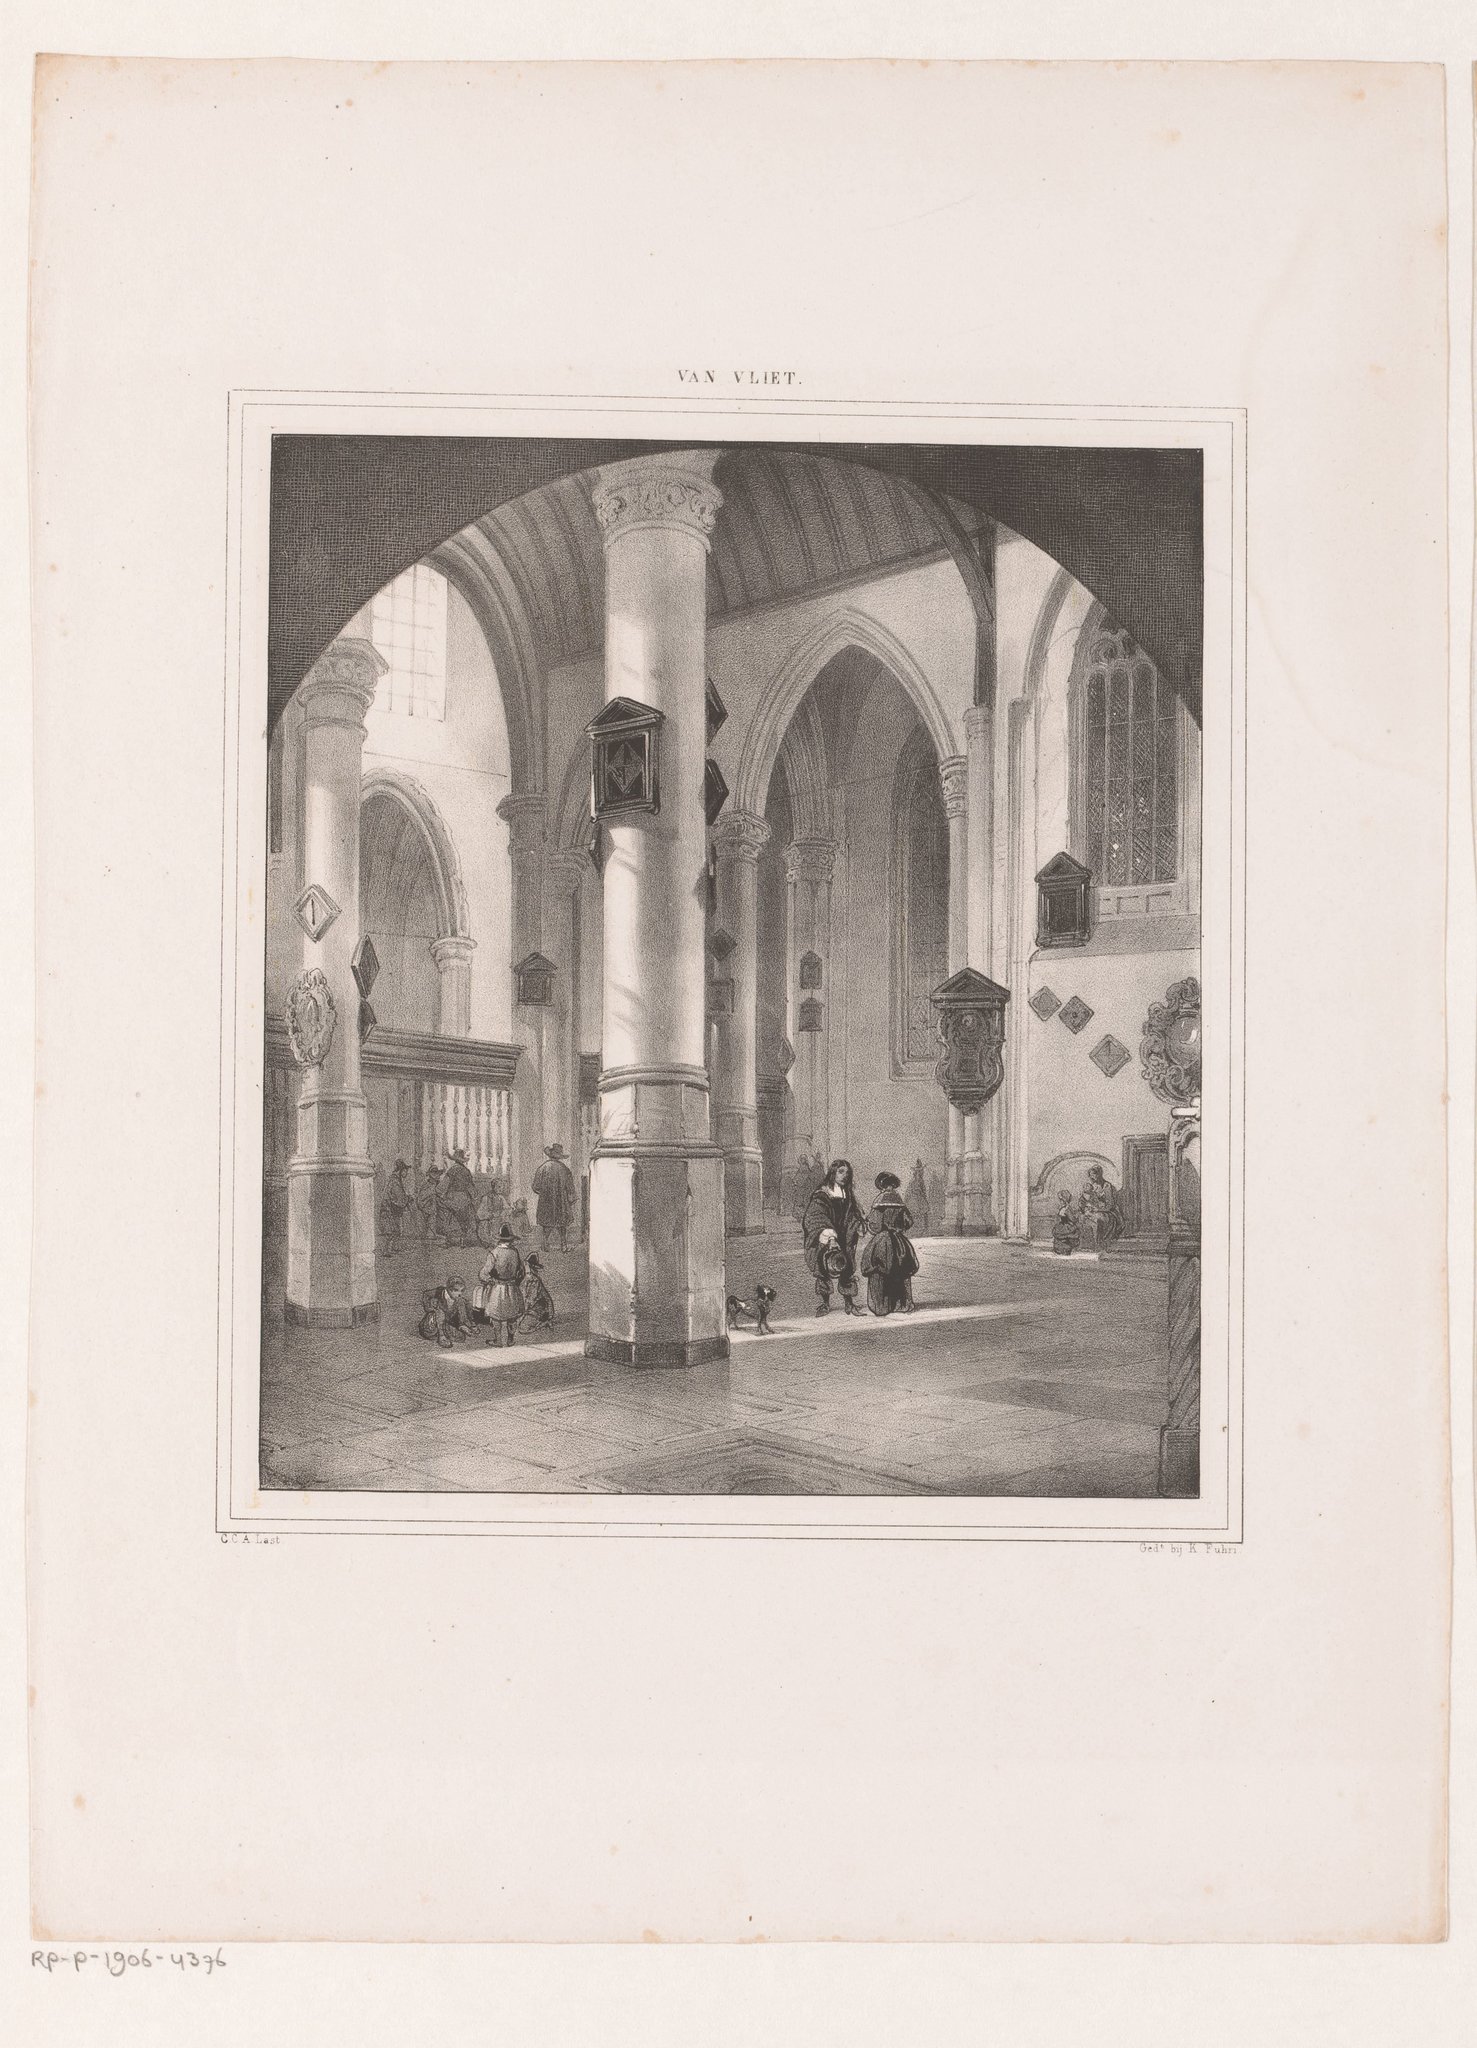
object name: print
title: Kerkinterieur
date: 1847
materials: paper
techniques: lithograph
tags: interior of church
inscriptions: collector's mark: Lugt 2228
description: Gezicht op een kerkinterieur met links het koorhek. In de kerk lopen figuren.